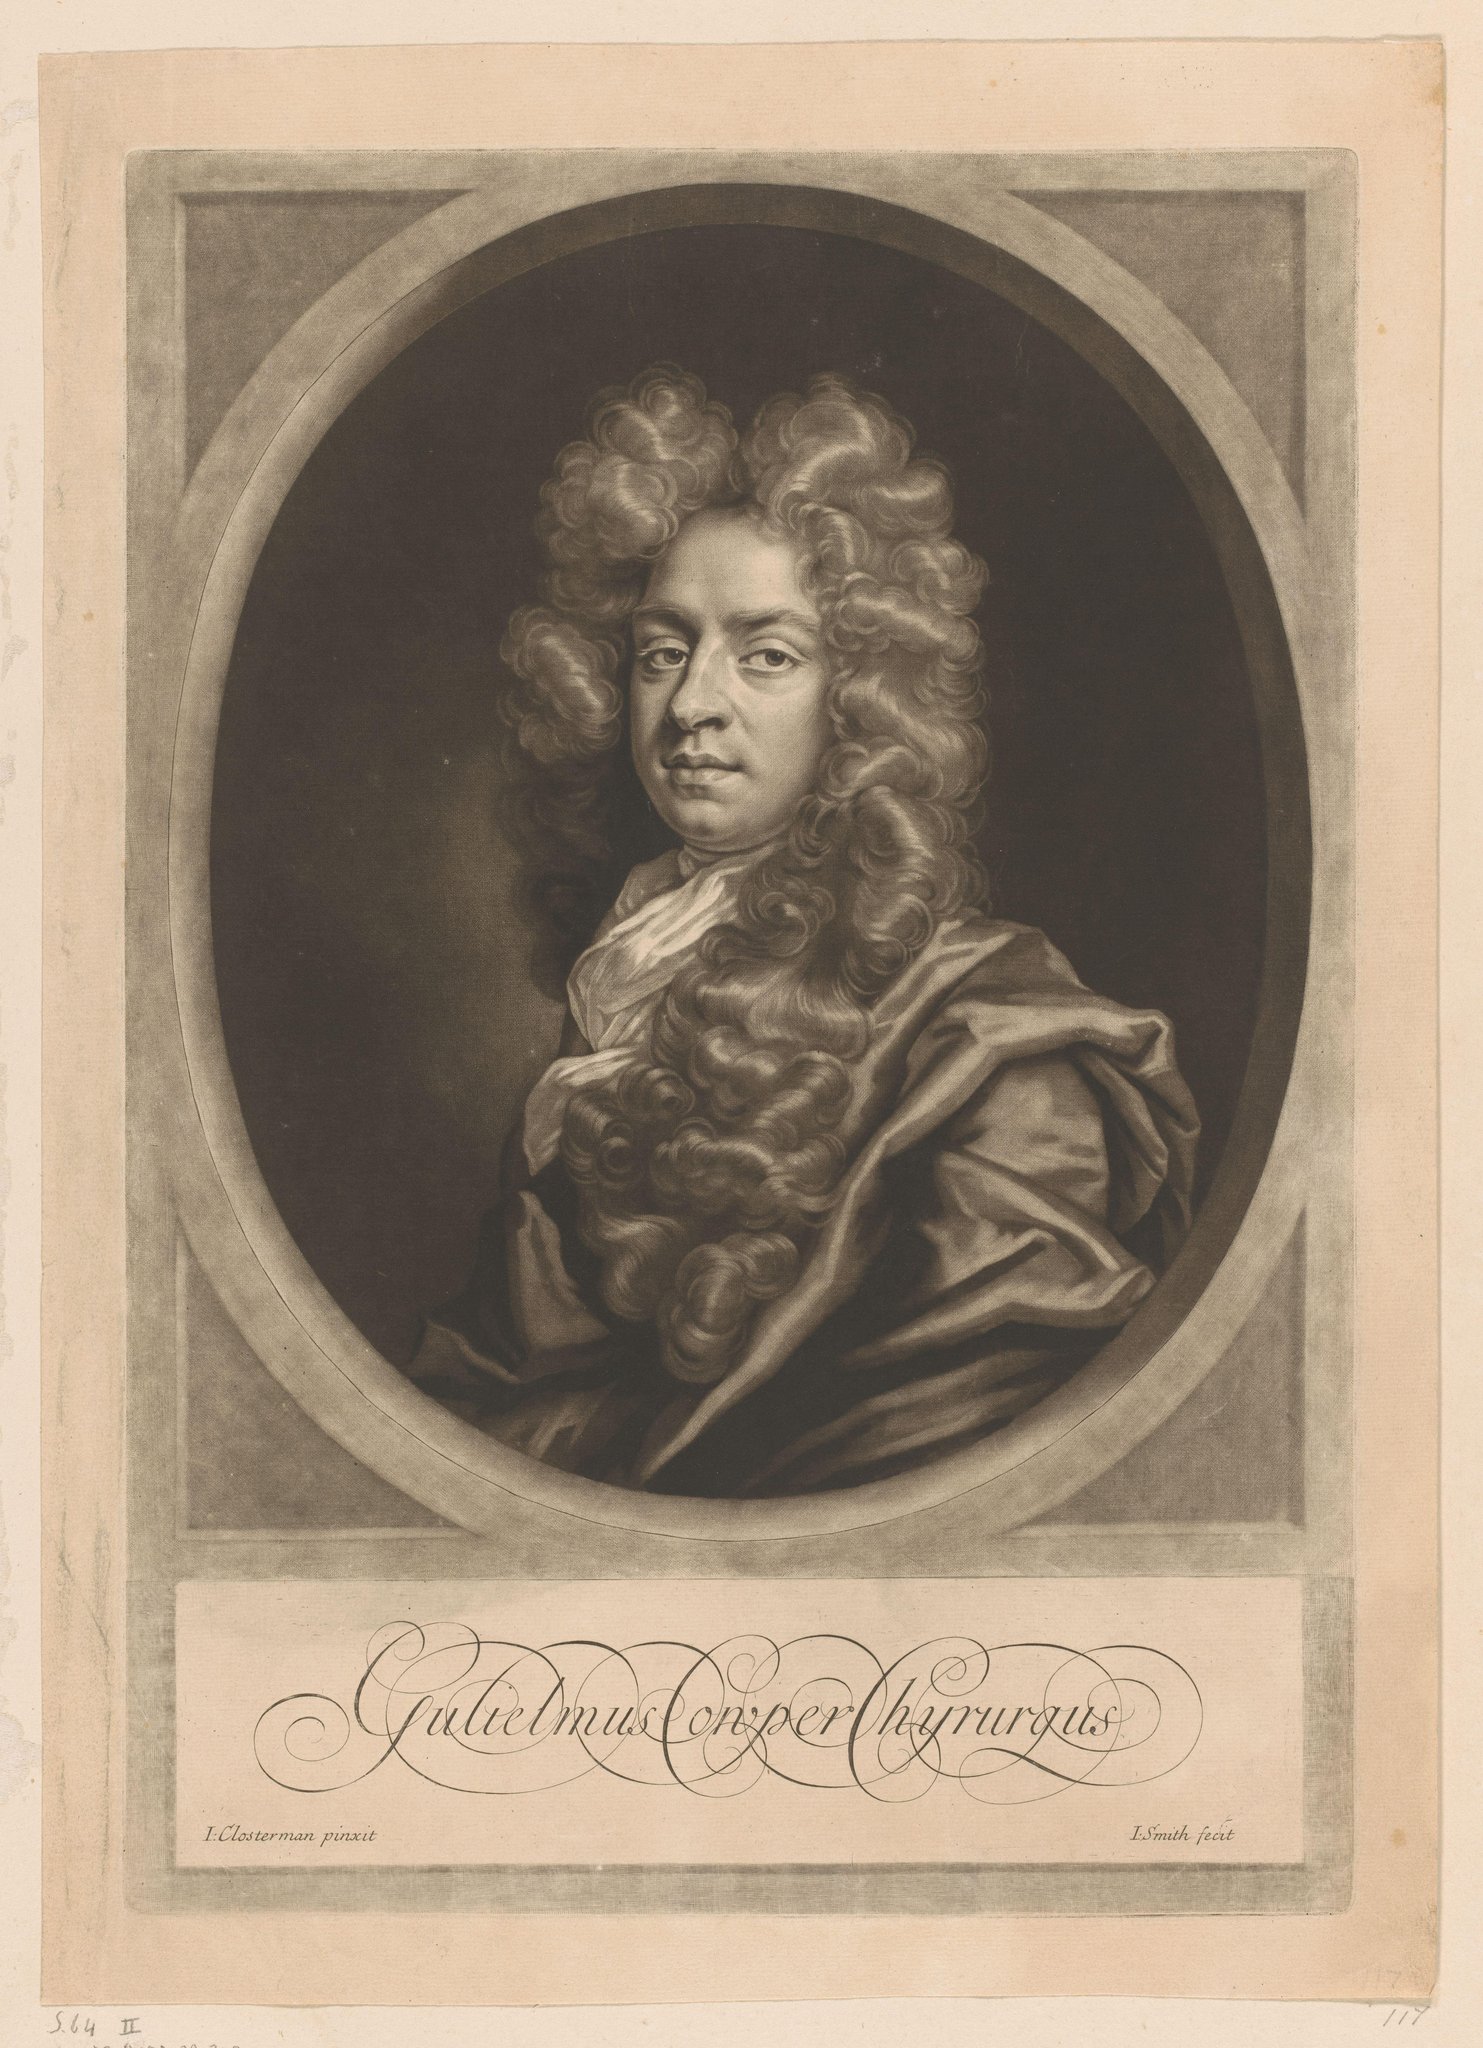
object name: print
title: Portret van William Cowper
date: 1662-1742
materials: paper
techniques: mezzotint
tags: earl, politician, historical persons, politician, e.g. party leader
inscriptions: collector's mark: Lugt 240